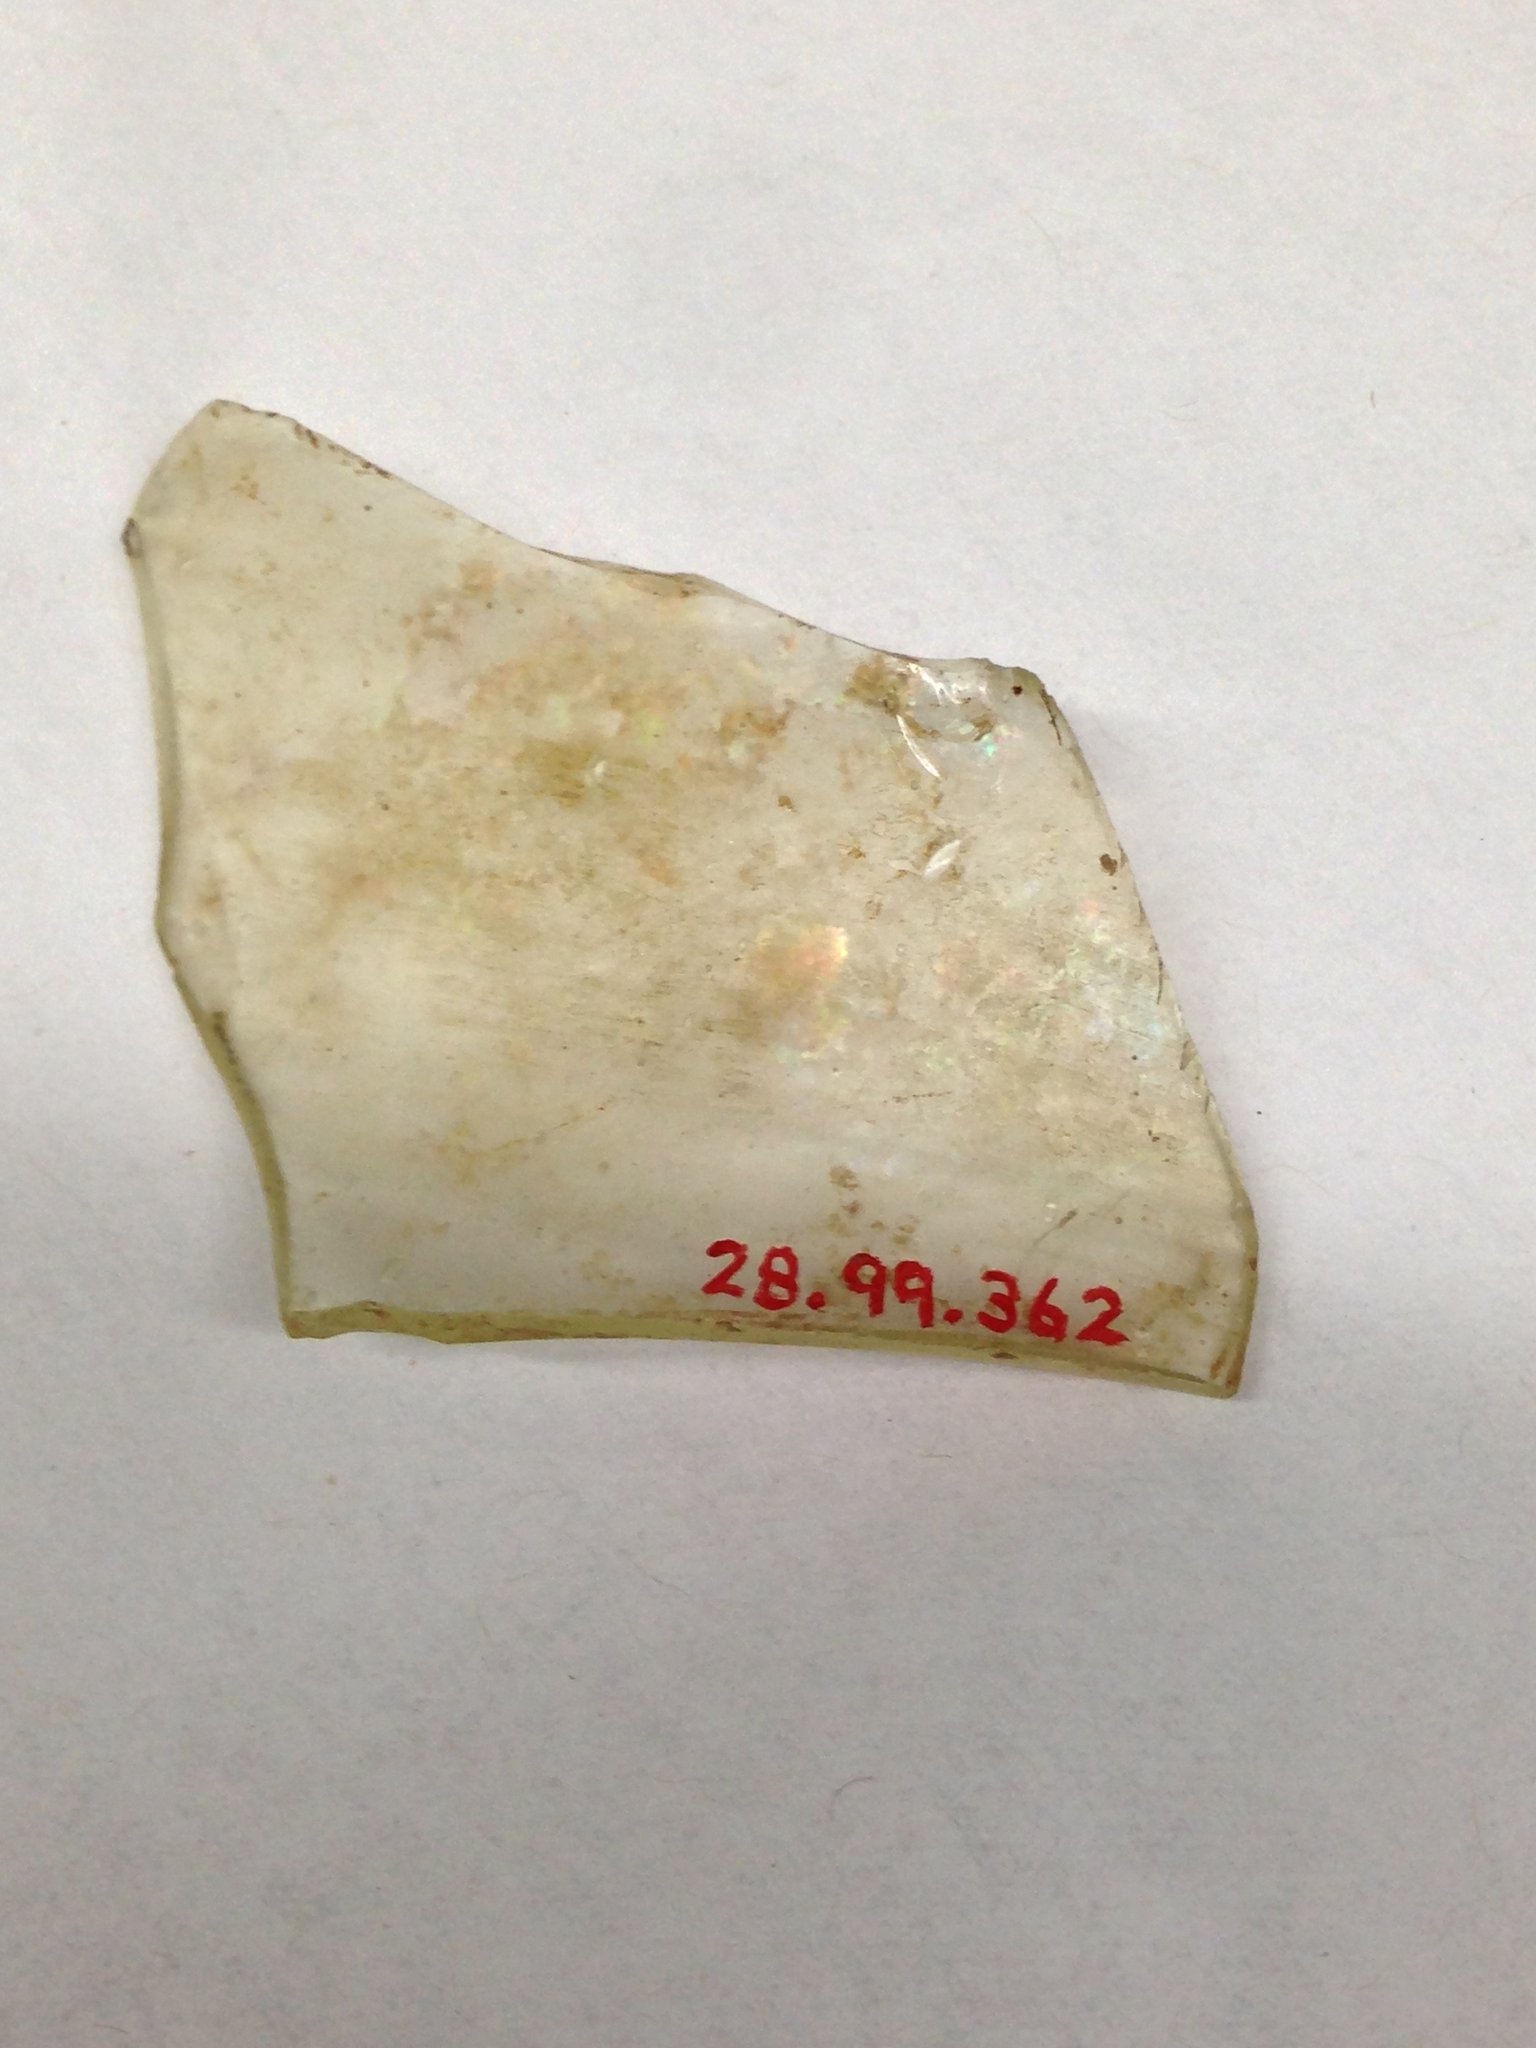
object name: fragment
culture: european or middle eastern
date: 1150-1250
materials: ceramic, glass